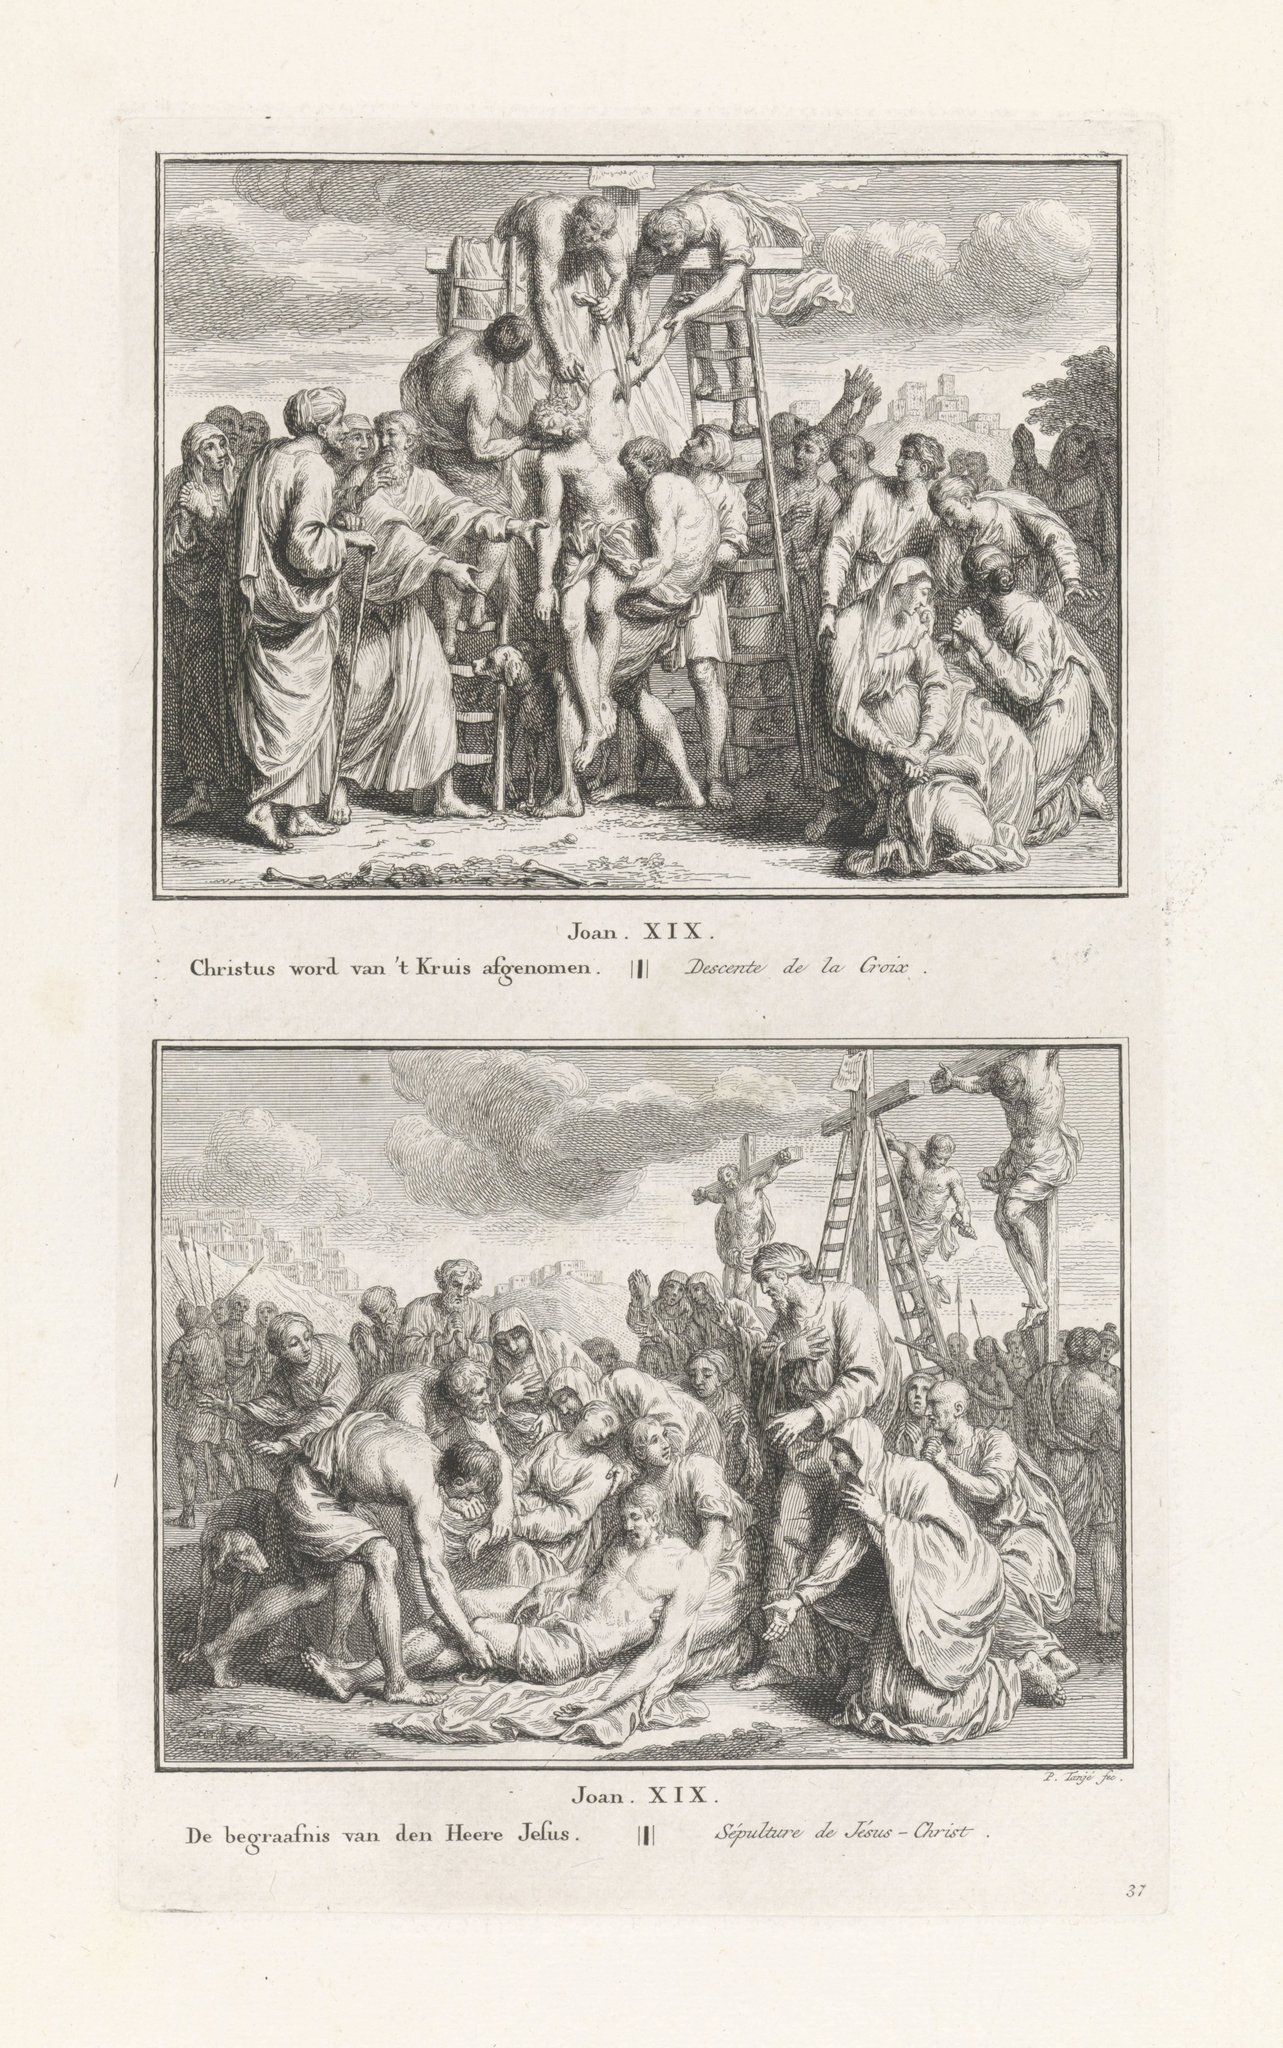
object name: book illustration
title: Christus word van 't Kruis afgenomen (...) / De begraafnis van den Heere Jesus (...)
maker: pieter tanjé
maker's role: draughtsman, print maker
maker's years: 1706-1761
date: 1716-1761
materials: paper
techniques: engraving, etching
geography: amsterdam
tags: descent from the cross: christ is taken down from the cross, usually by nicodemus and joseph of arimathaea who are standing on the ladders (both arms of christ detached), lamentation over the dead christ by his relatives and friends (christ usually without crown of thorns)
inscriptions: collector's mark: Lugt 2233, collector's mark: Lugt 3937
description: Prent mogelijk gebruikt in: Hamelsveld, Ysbrand van. De gewigtigste geschiedenissen des Bybels, afgebeeld in twee honderd twee en vĳftig printverbeeldingen (...) met eene zaaklĳke uitbreiding opgehelderd. Amsterdam: Jan de Groot, Gerrit Warnars, Petrus van Hengst, Dordrecht: Abraham Blussé, Pieter Blussé, Leiden: Samuel Luchtmans (III), Johannes Luchtmans, Harlingen: Volkert van der Plaats, 1791.